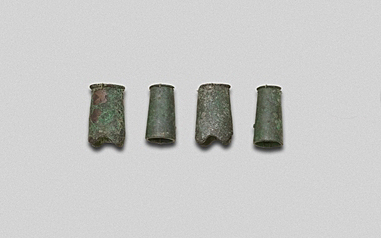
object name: chariot fragment, socket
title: Fragments of a cart or chariot, sockets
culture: etruscan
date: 500-480 BCE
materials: bronze